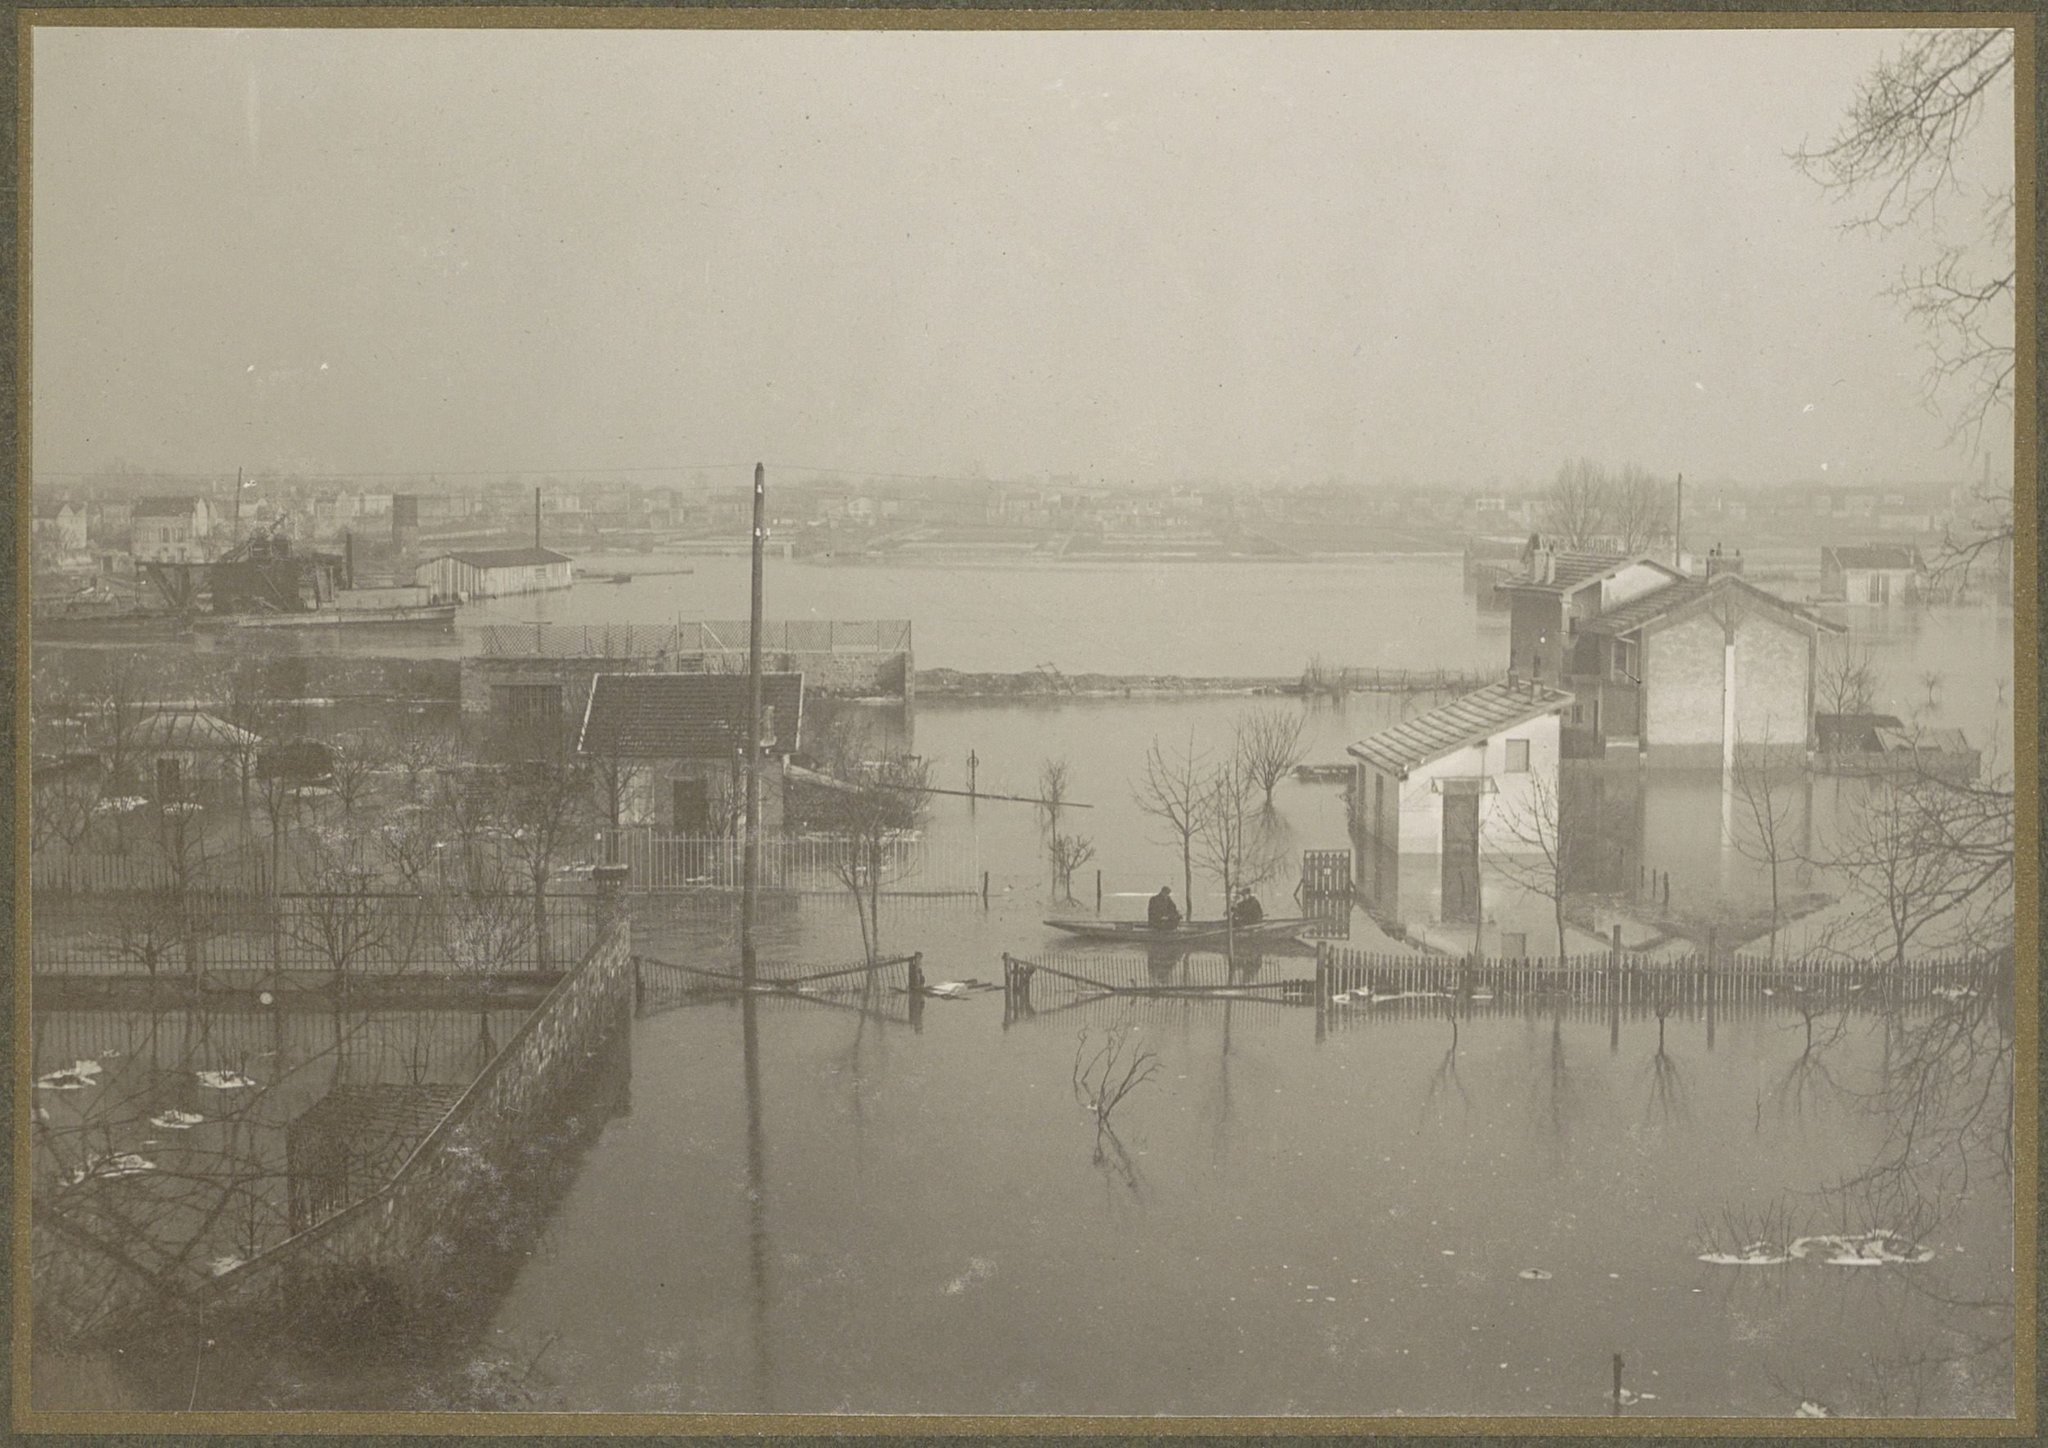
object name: photograph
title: Panoramisch uitzicht op een ondergelopen buitenwijk van Parijs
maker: g. dangereux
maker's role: fotograaf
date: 1901-1910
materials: photographic support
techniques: matte daylight collodion silver print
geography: paris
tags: flood (+ landscape with figures, staffage), garden, paris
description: Onderdeel van fotoalbum overstroming Parijs en voorsteden 1910.